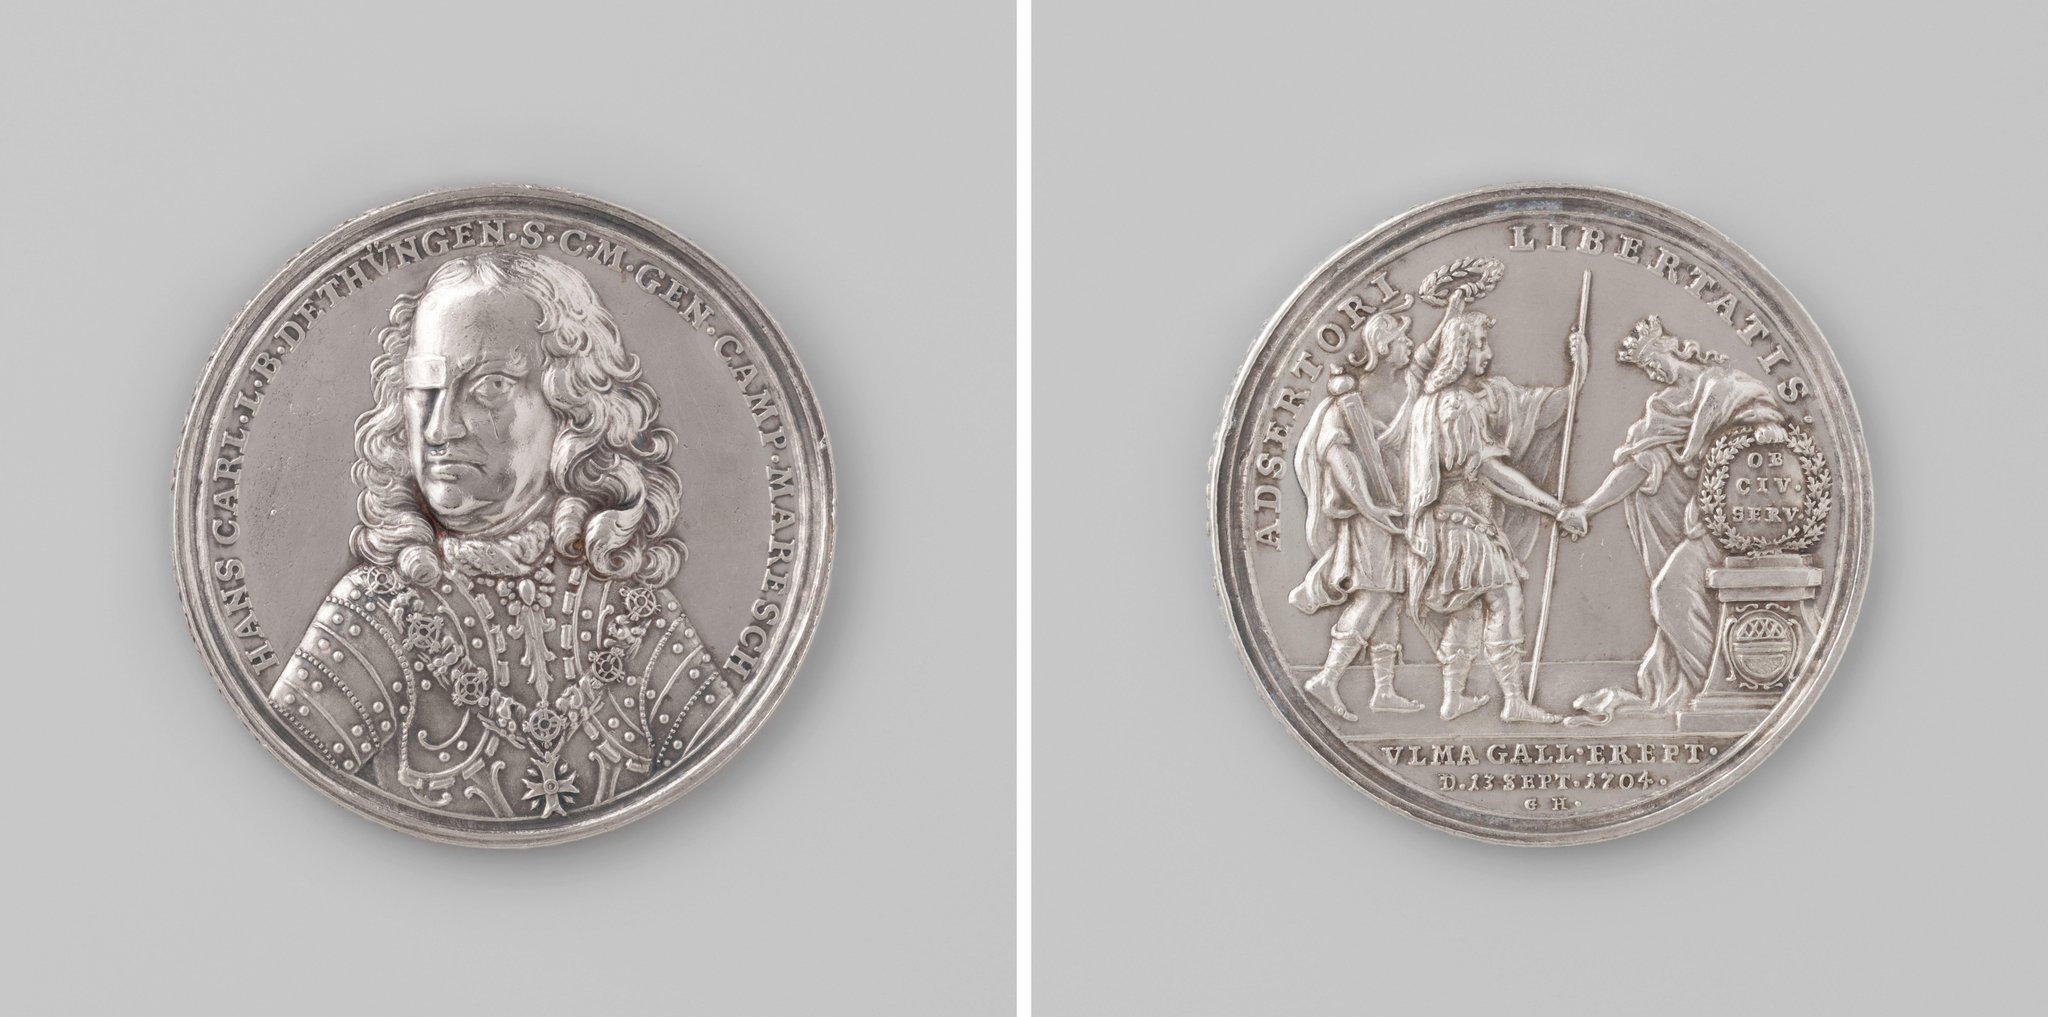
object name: history medal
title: Inname van Ulm, ter ere van Hans Karel, vrijbaanderheer van Thungen, veldmaarschalk van de keizer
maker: georg hautsch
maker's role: medailleur, muntmaker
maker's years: 1679-1745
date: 1704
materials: silver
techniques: striking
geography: nuremberg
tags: hans karel thungen, ulm, baden-württemberg, inname van ulm (1704)